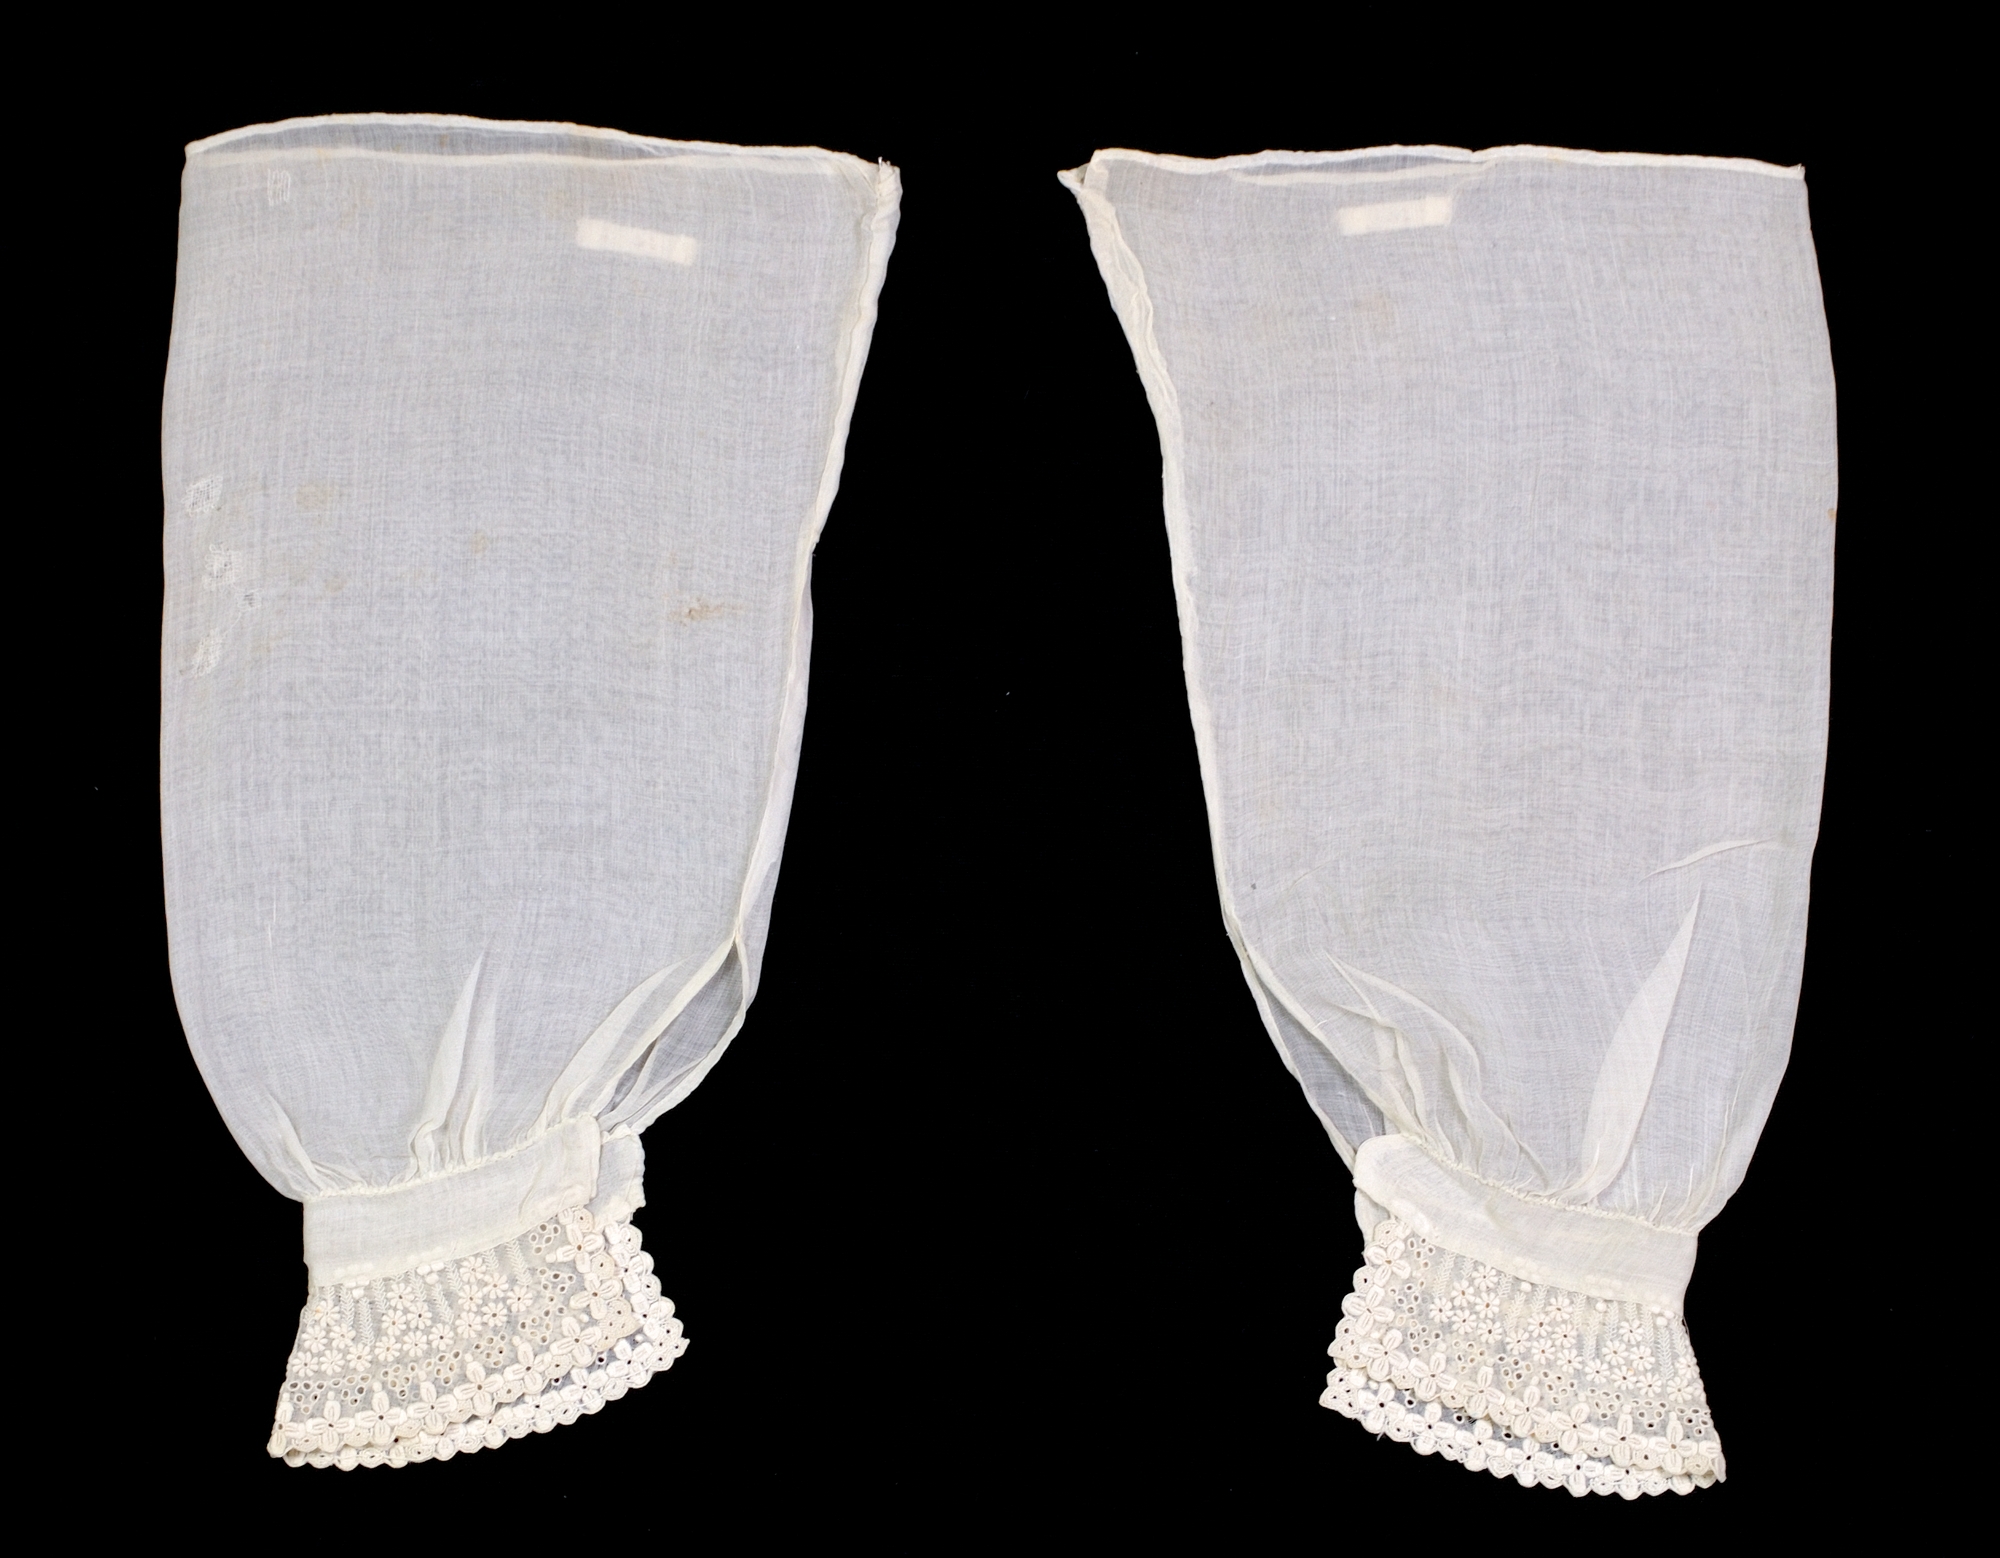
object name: undersleeves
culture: american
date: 1860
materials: cotton